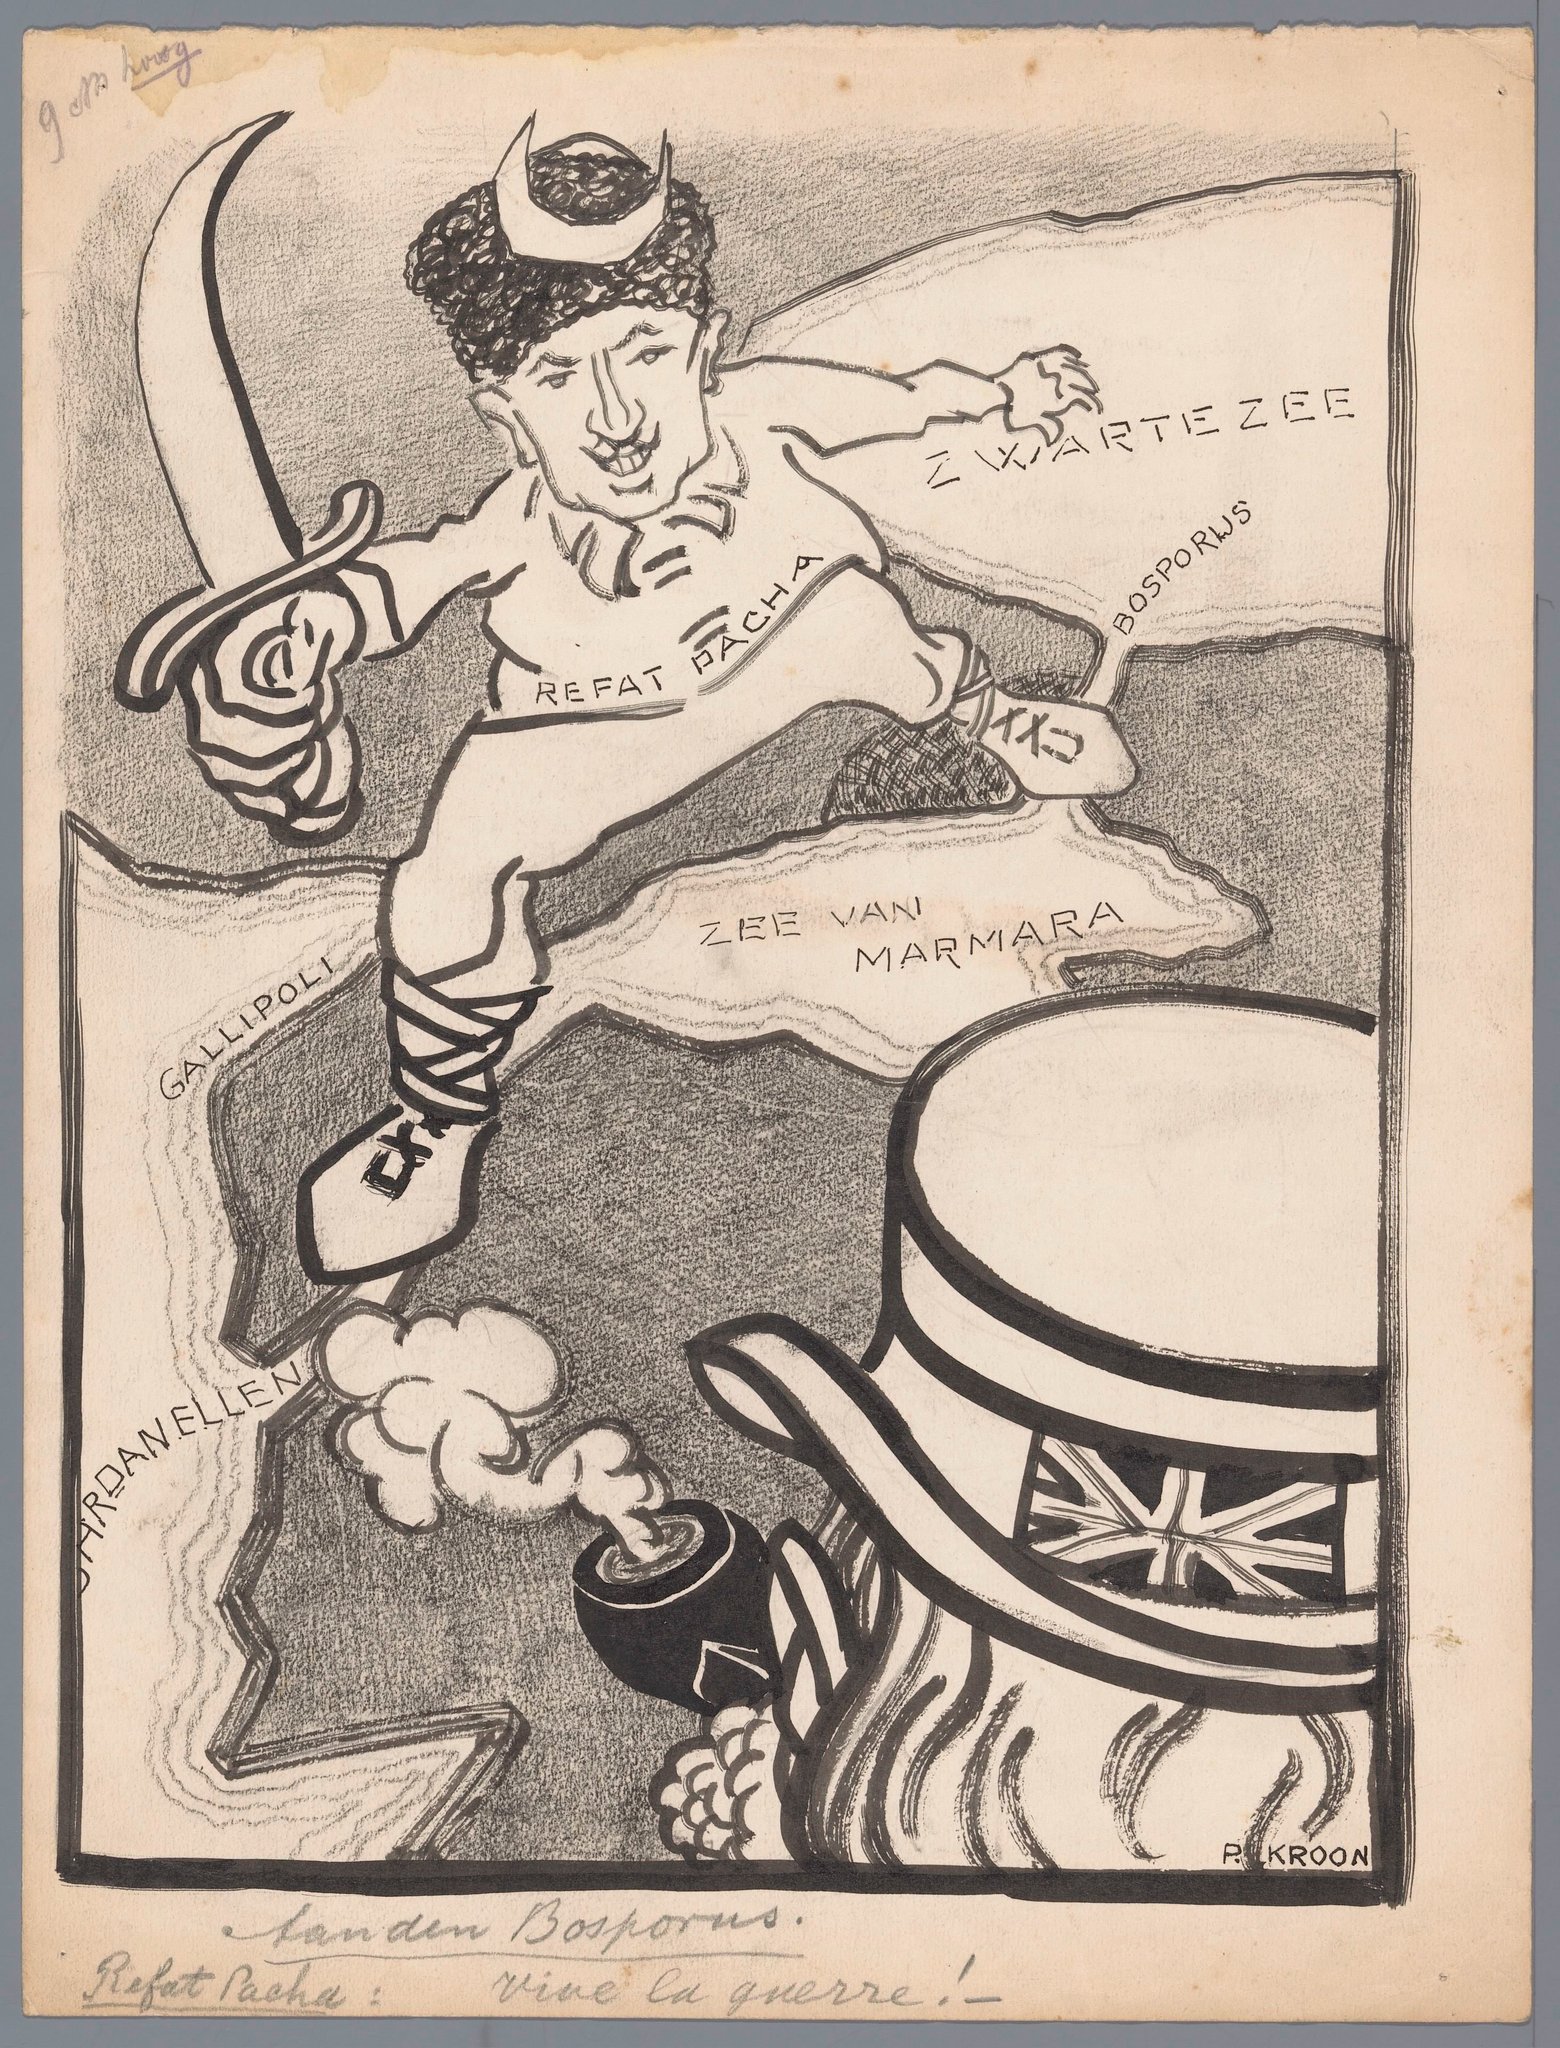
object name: cartoon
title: Aan den Bosporus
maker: patricq kroon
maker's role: draughtsman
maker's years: 1862-1941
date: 1915-1925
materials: paper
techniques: pen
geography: netherlands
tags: personifications of countries, nations, states, districts, etc., political caricatures and satires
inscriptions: number: ‘14366’, inscription: ‘Aan den Bosporus. refat Pacha: Vive la guerre!’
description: De Turk Refat Pacha wacht met getrokken zwaard John Bull (Engeland) op aan de Bosporus. Ontwerp voor een politieke spotprent.